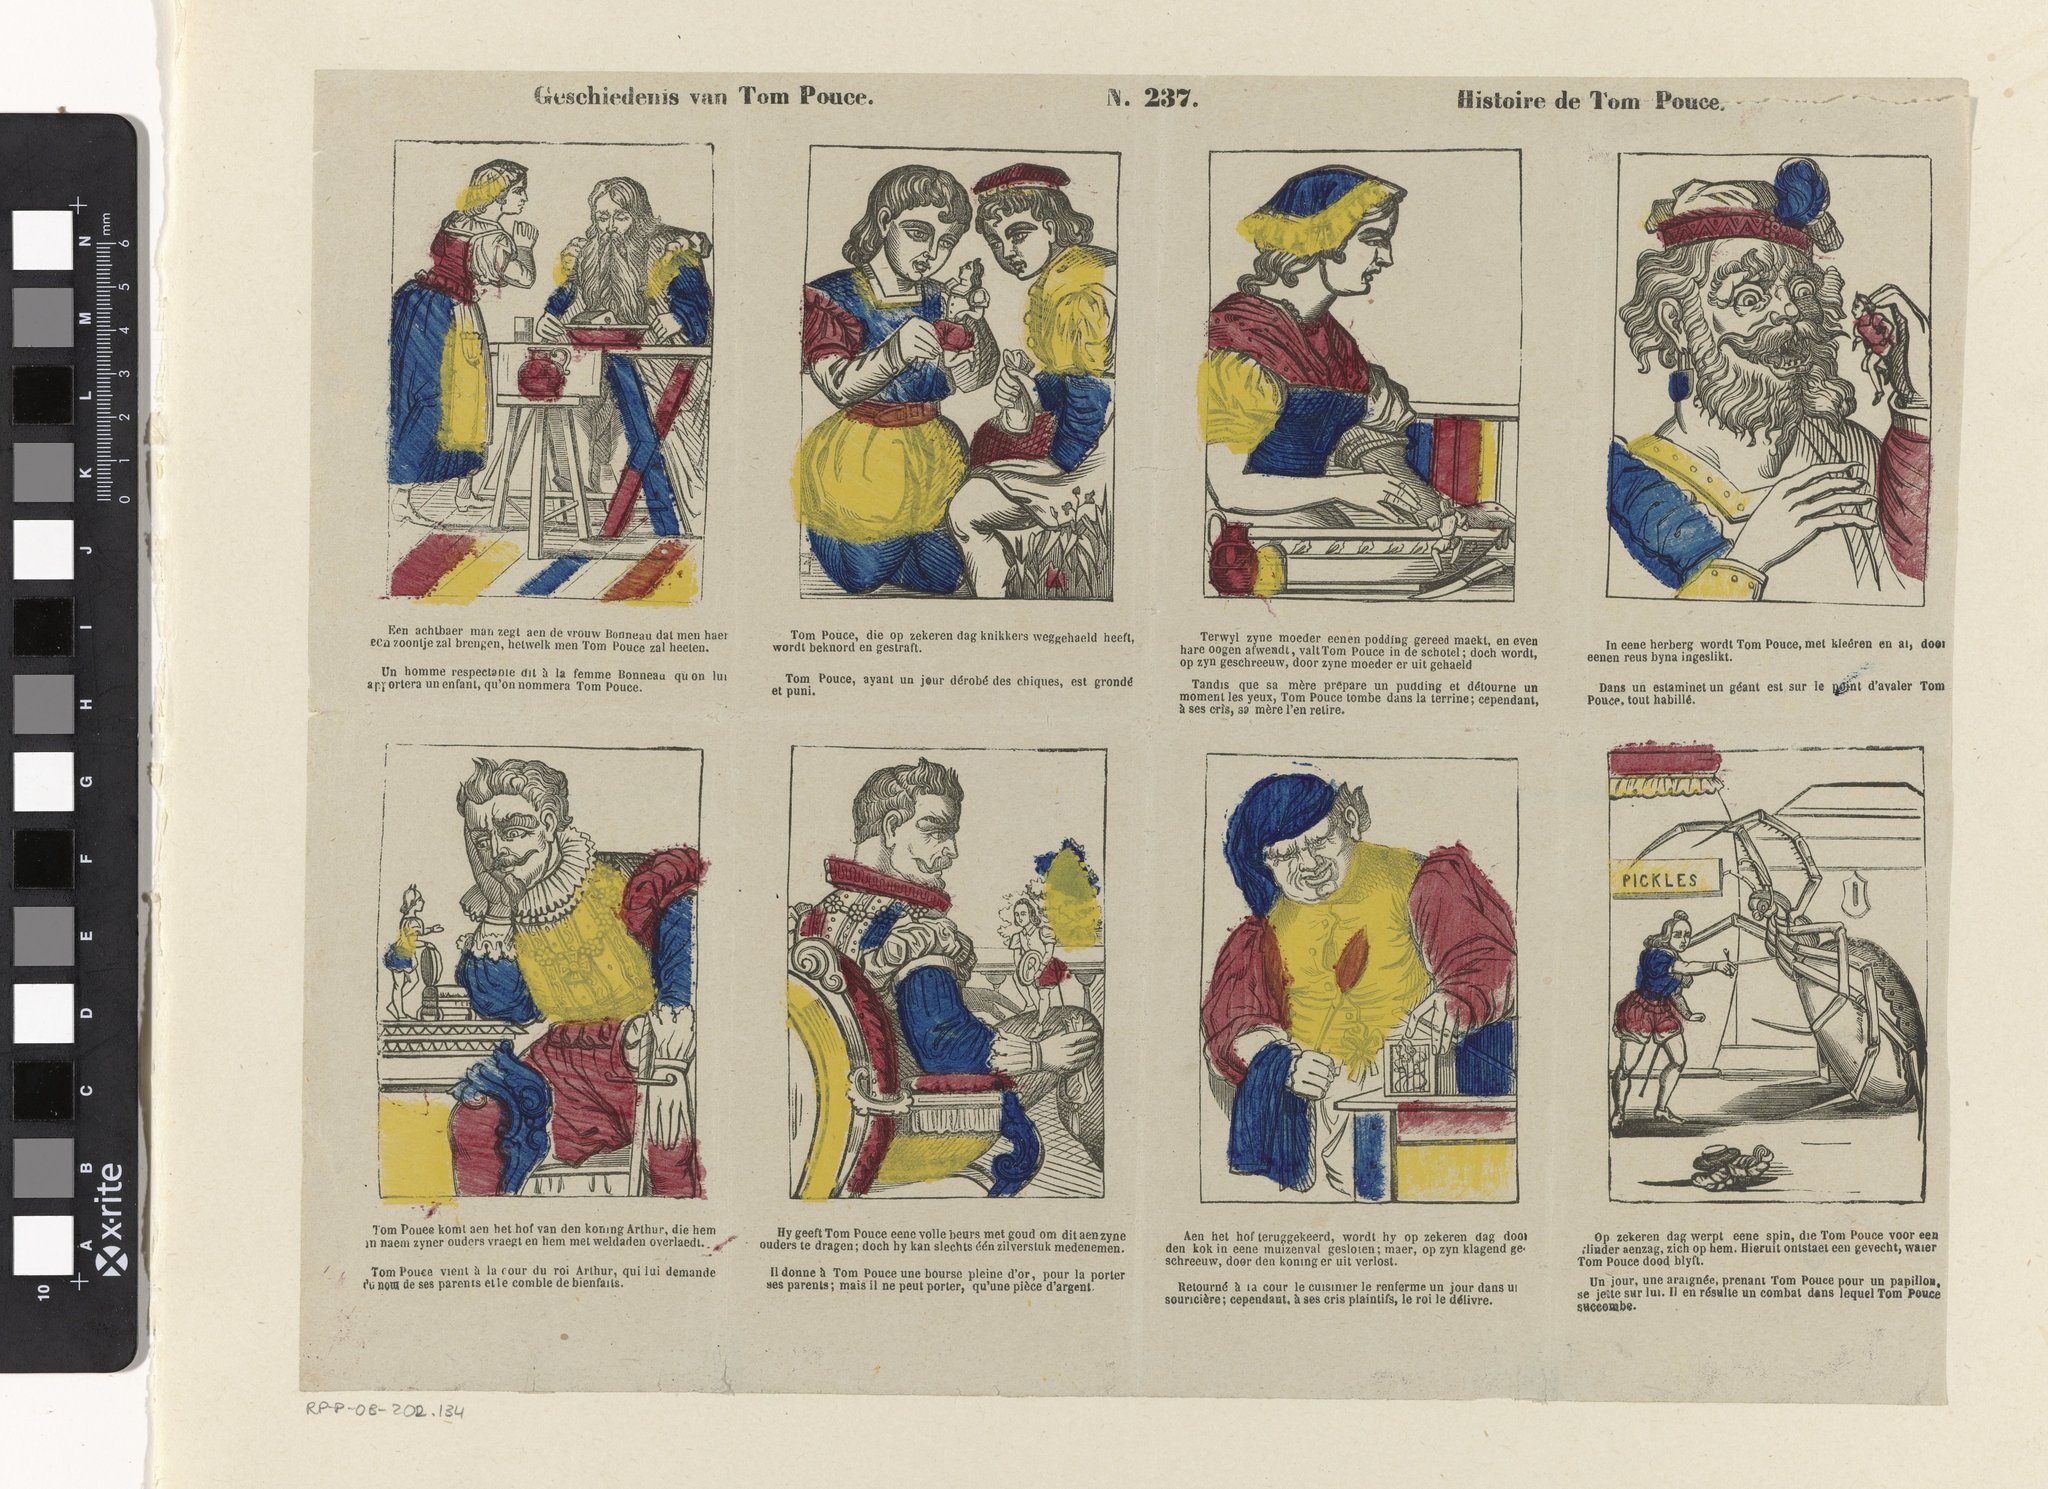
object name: popular print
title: Geschiedenis van Klein Duimken / Histoire de Tom Pouce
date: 1800-1833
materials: paper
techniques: colour, letterpress printing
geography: turnhout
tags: tales and fairy tales: little thumbling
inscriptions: collector's mark: Lugt 2760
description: Blad met 8 voorstellingen uit het verhaal van Klein Duimpje. Onder elke afbeelding een onderschrift in het Nederlands en in het Frans. Genummerd midden boven: N. 237.